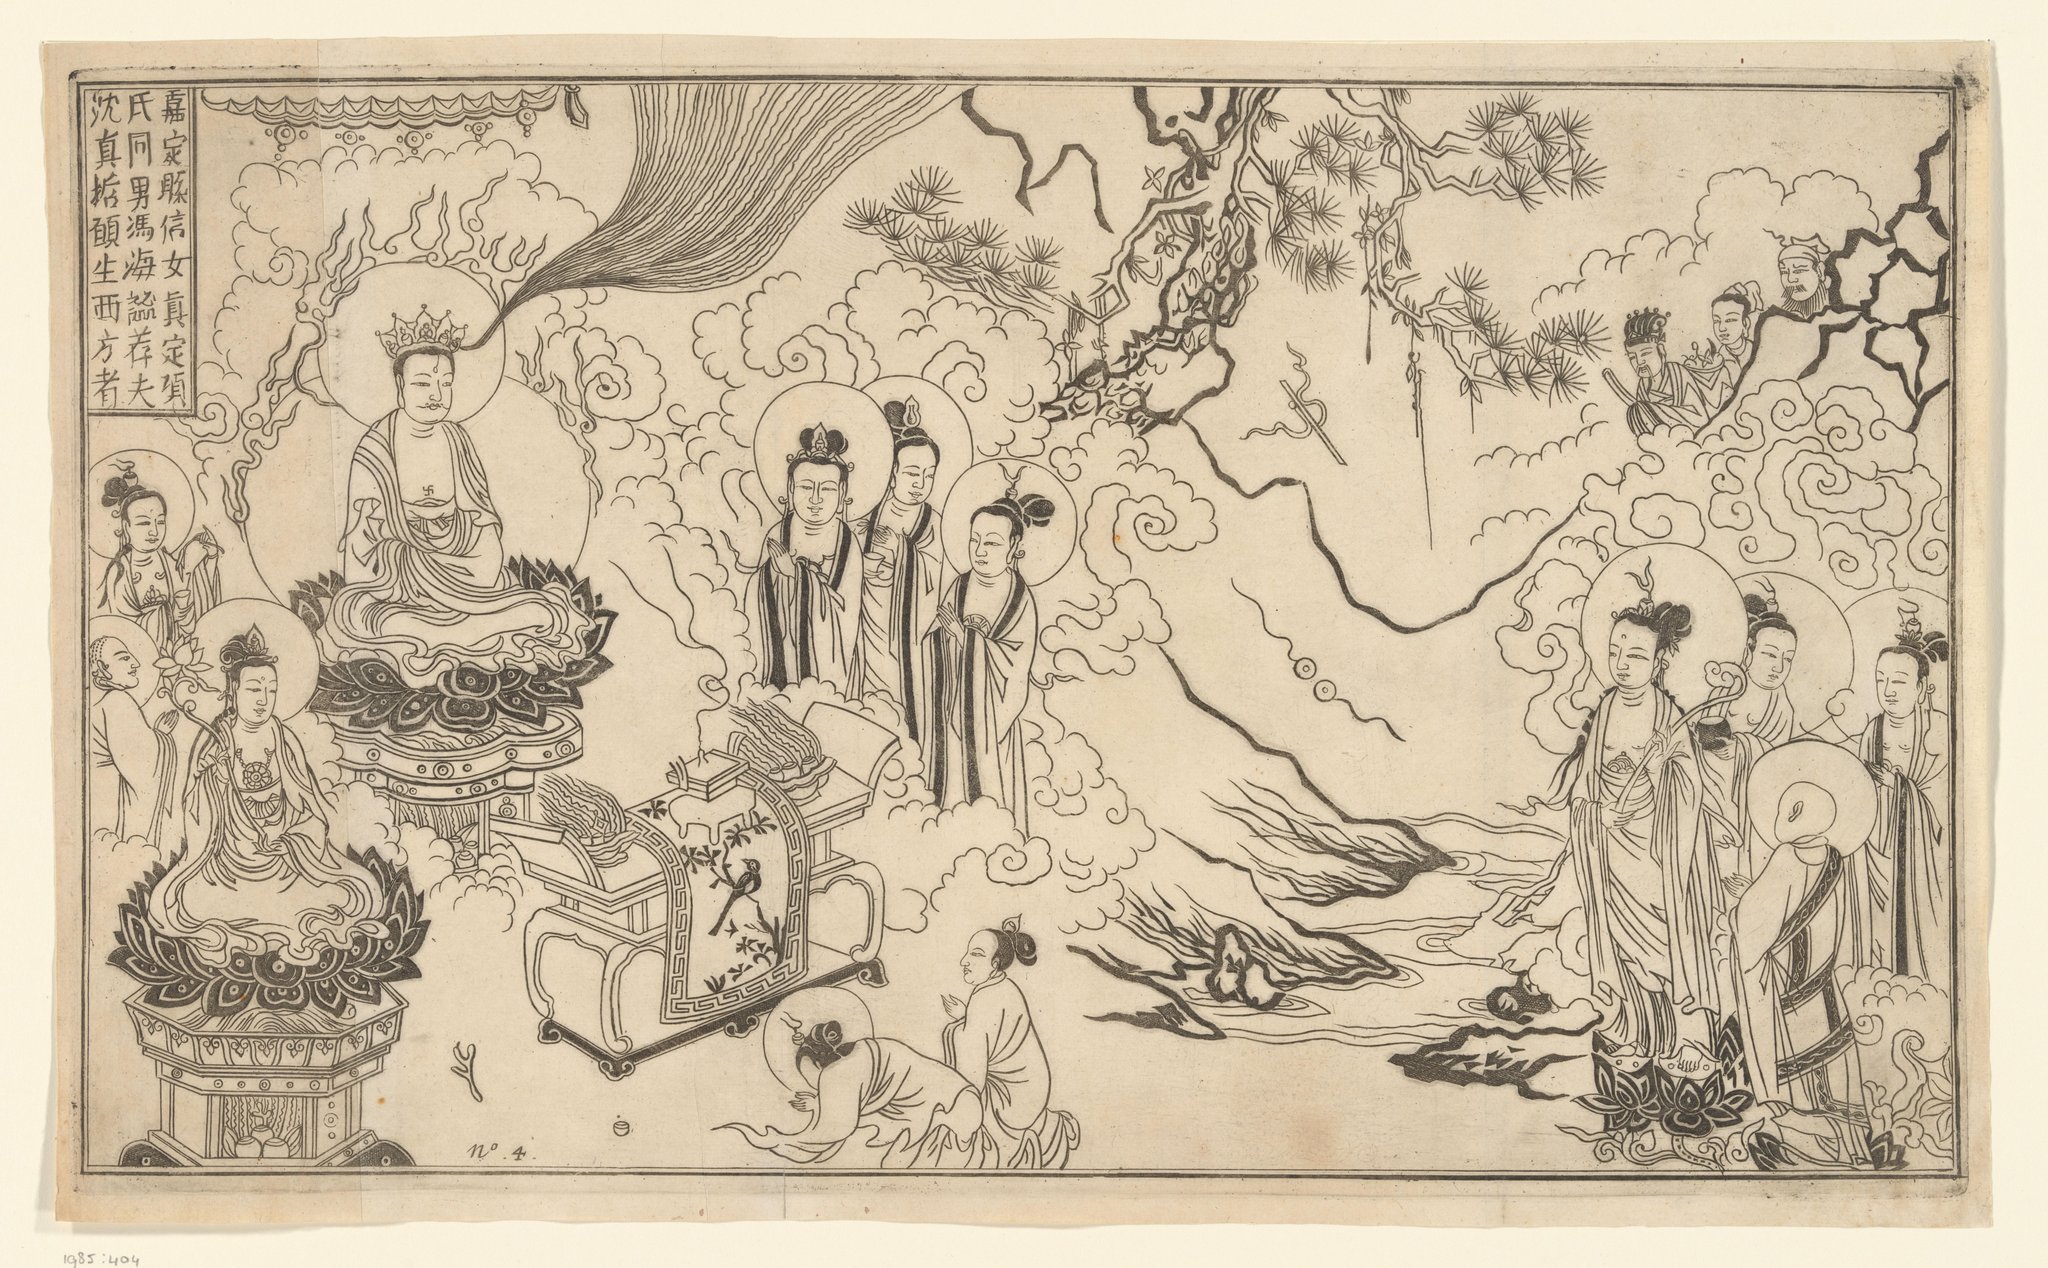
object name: print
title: Fourth Sheet in a Series of Four Featuring Chinese Depictions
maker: Anonymous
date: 1670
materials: paper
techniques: engraving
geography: amsterdam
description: Made for the European elite, these illustrations were meant to portray the ‘exotic’ Far East. They contributed to the Eurocentric image of China. Additionally, they played a role in the subsequent craze for Chinoiserie: decorations featuring all kinds of, often inaccurate, ‘Chinese’ elements. This accurate illustration of an enlightened Buddha was later also adapted in Delftware.